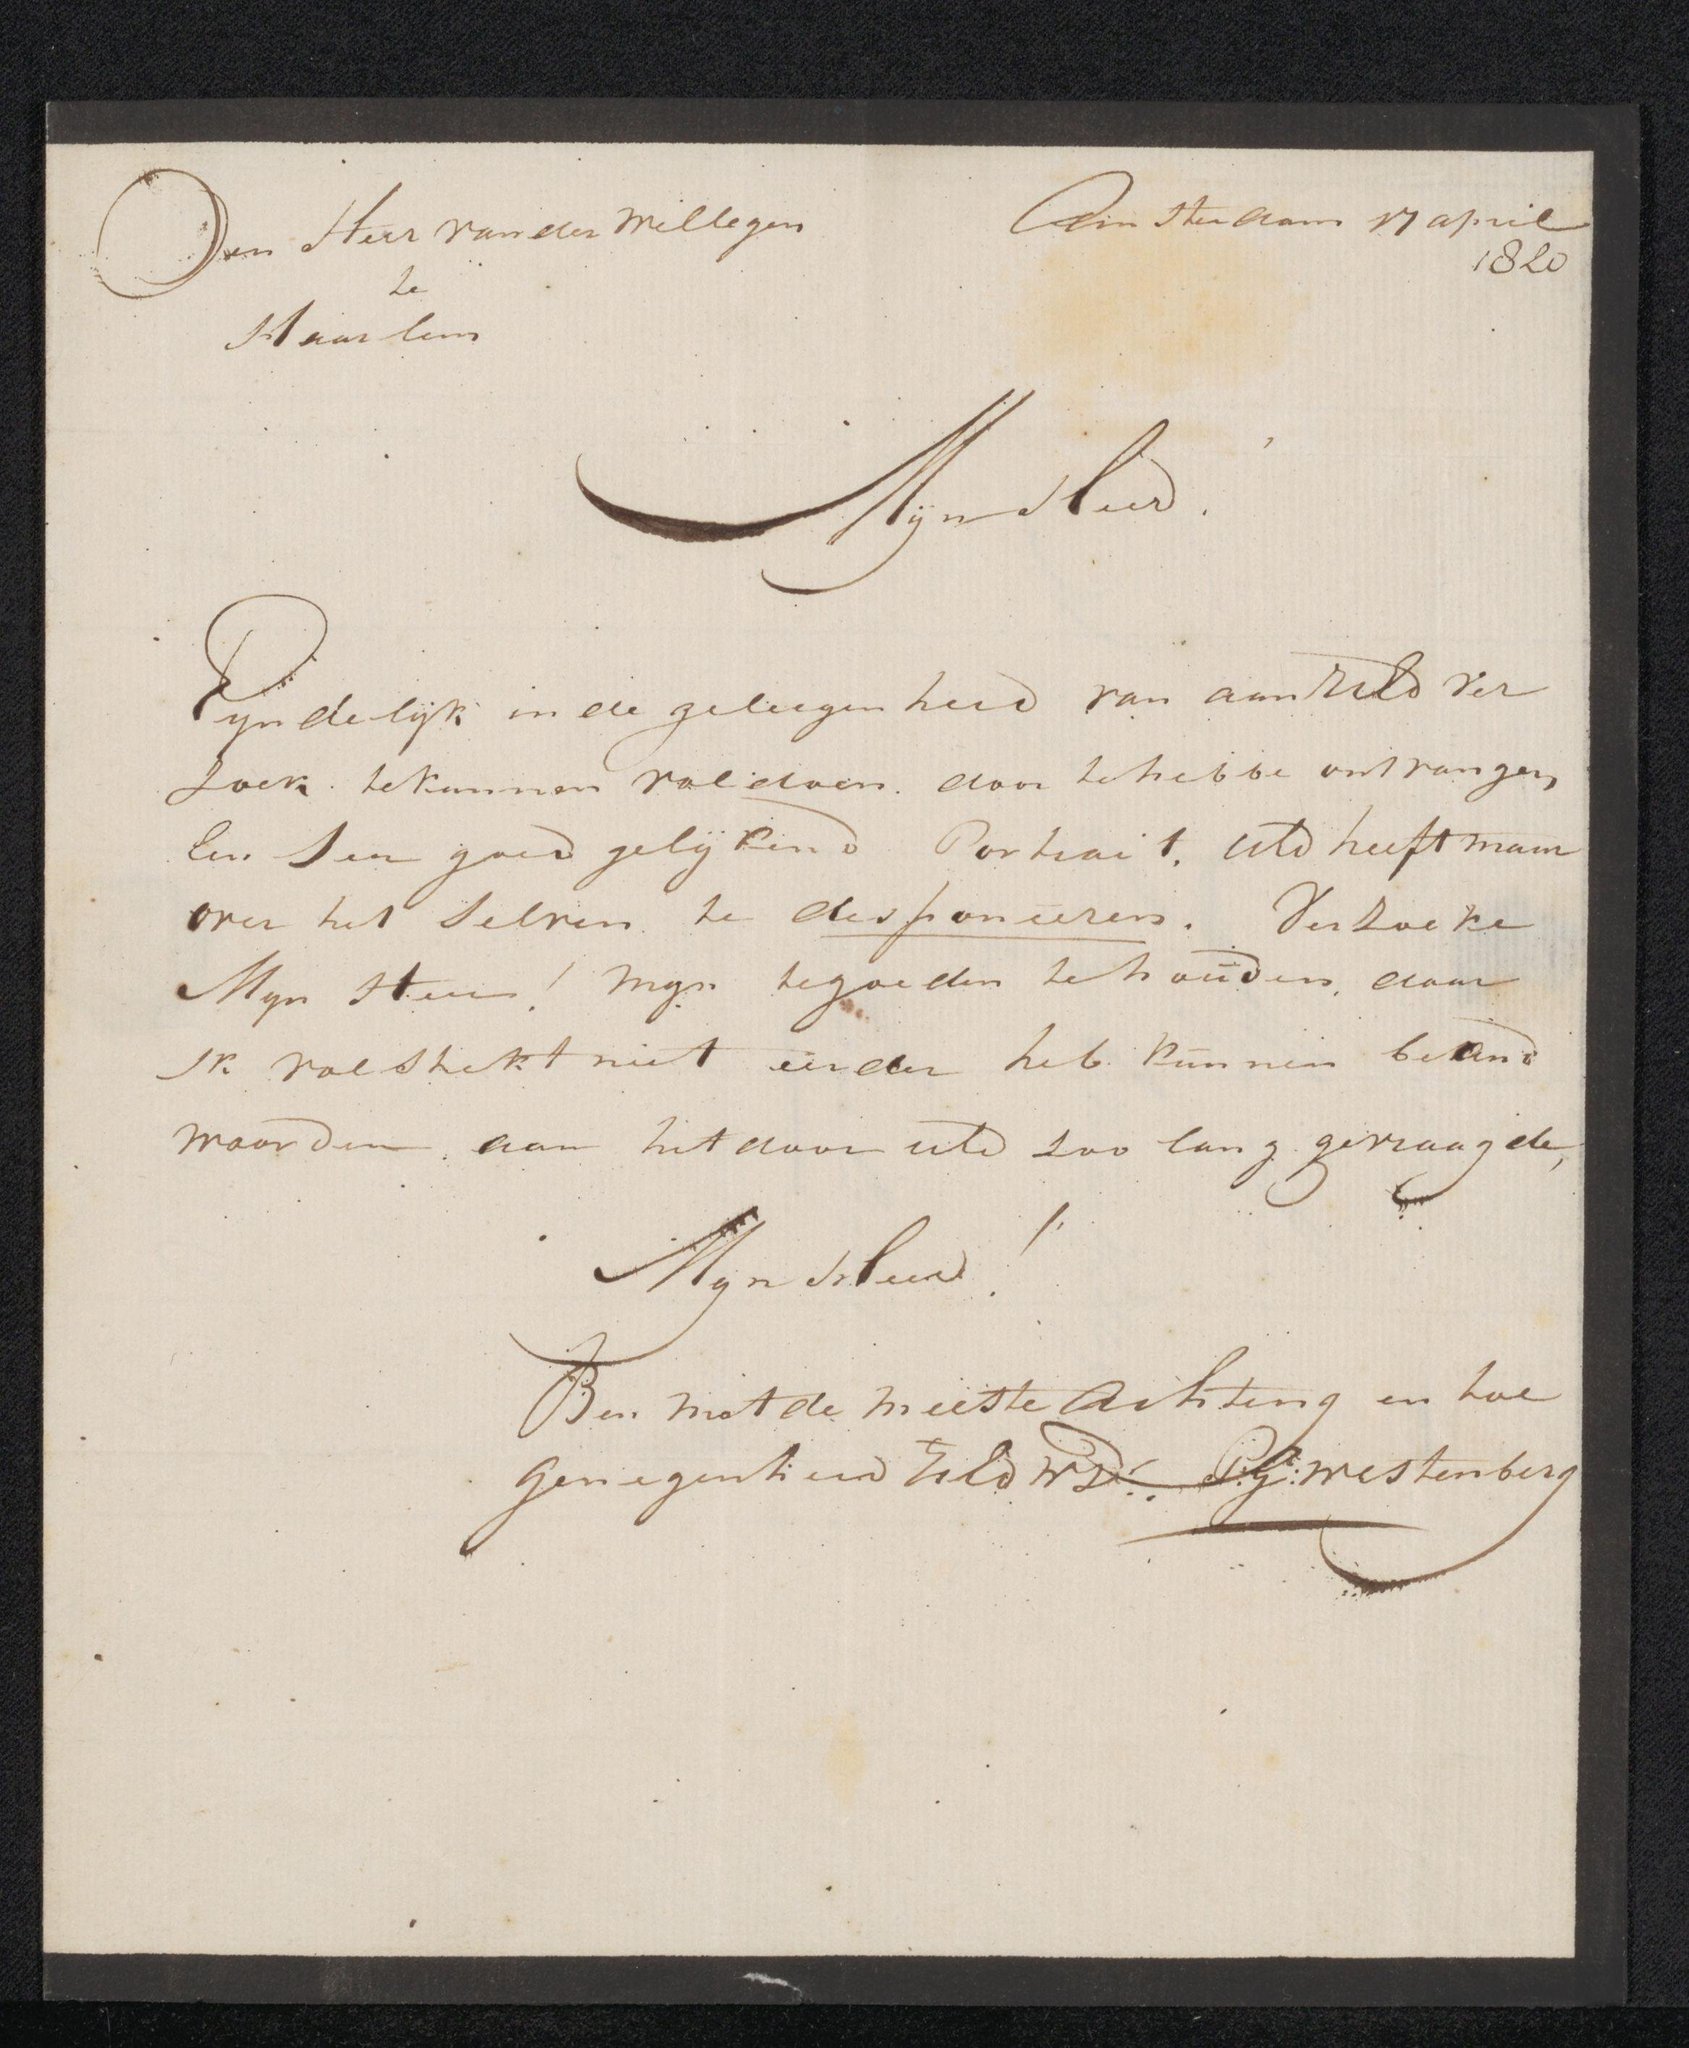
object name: letter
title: Brief aan Adriaan van der Willigen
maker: george pieter westenberg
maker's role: draughtsman, painter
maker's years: 1791-1873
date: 1820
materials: ink, paper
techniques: pen, writing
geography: amsterdam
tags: rotterdam, haarlem, adriaan van der willigen, historical persons (portraits and scenes from the life)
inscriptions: watermark